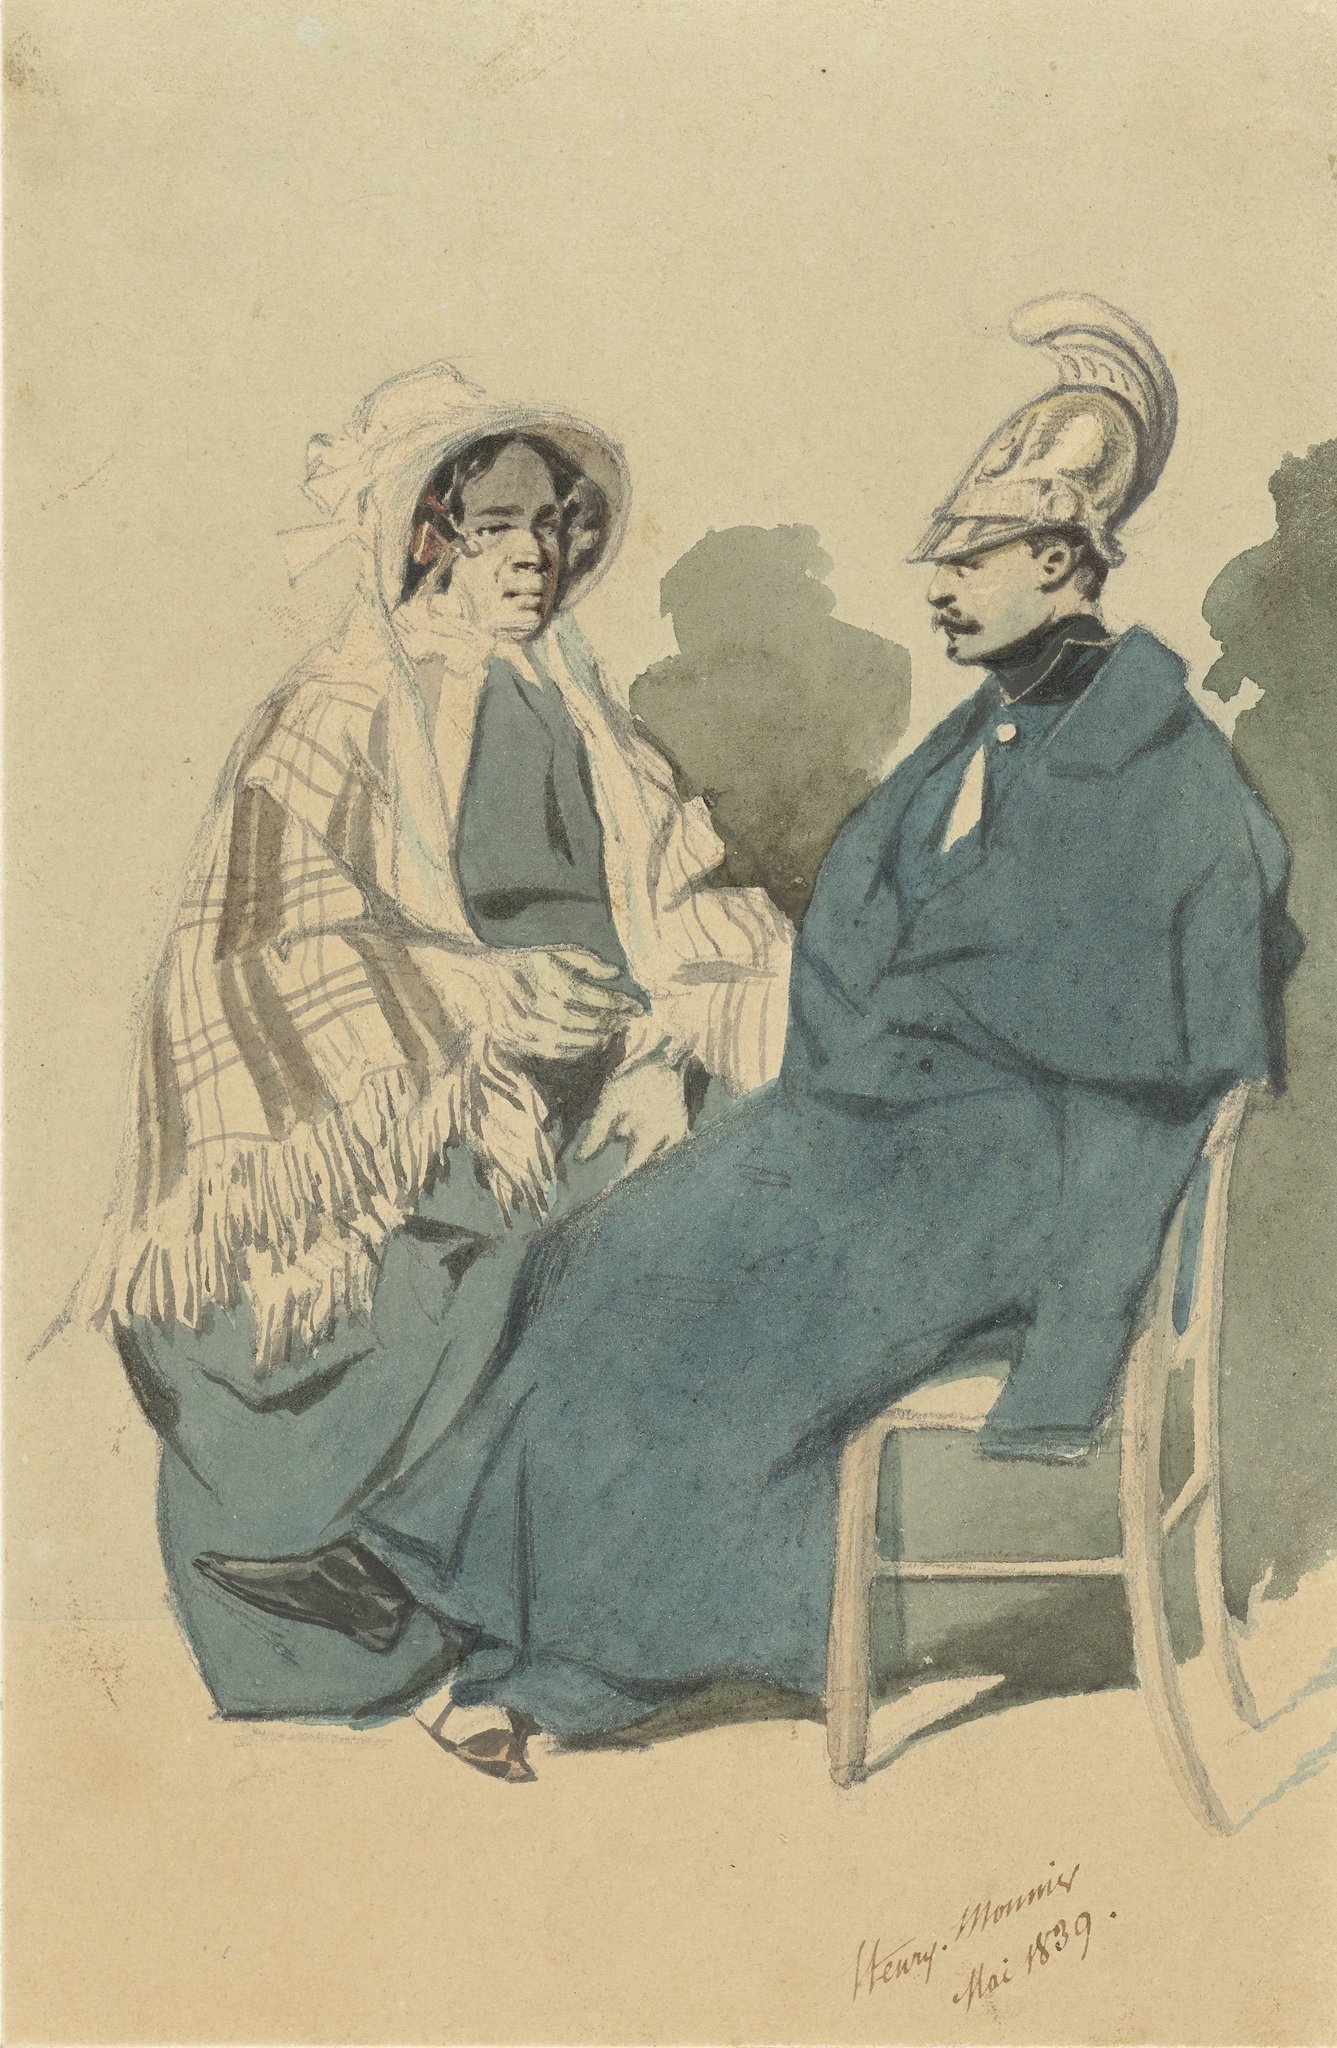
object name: drawing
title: Kurassier met helm en blauwe mantel, zittend naast een oude dame in reistoilet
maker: henry bonaventure monnier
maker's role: draughtsman, print maker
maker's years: 1799-1877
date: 1805-1839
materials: paper, pencil, watercolor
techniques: brush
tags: thes soldier off duty (+ cavalry, horsemen), 'en route', traveller under way